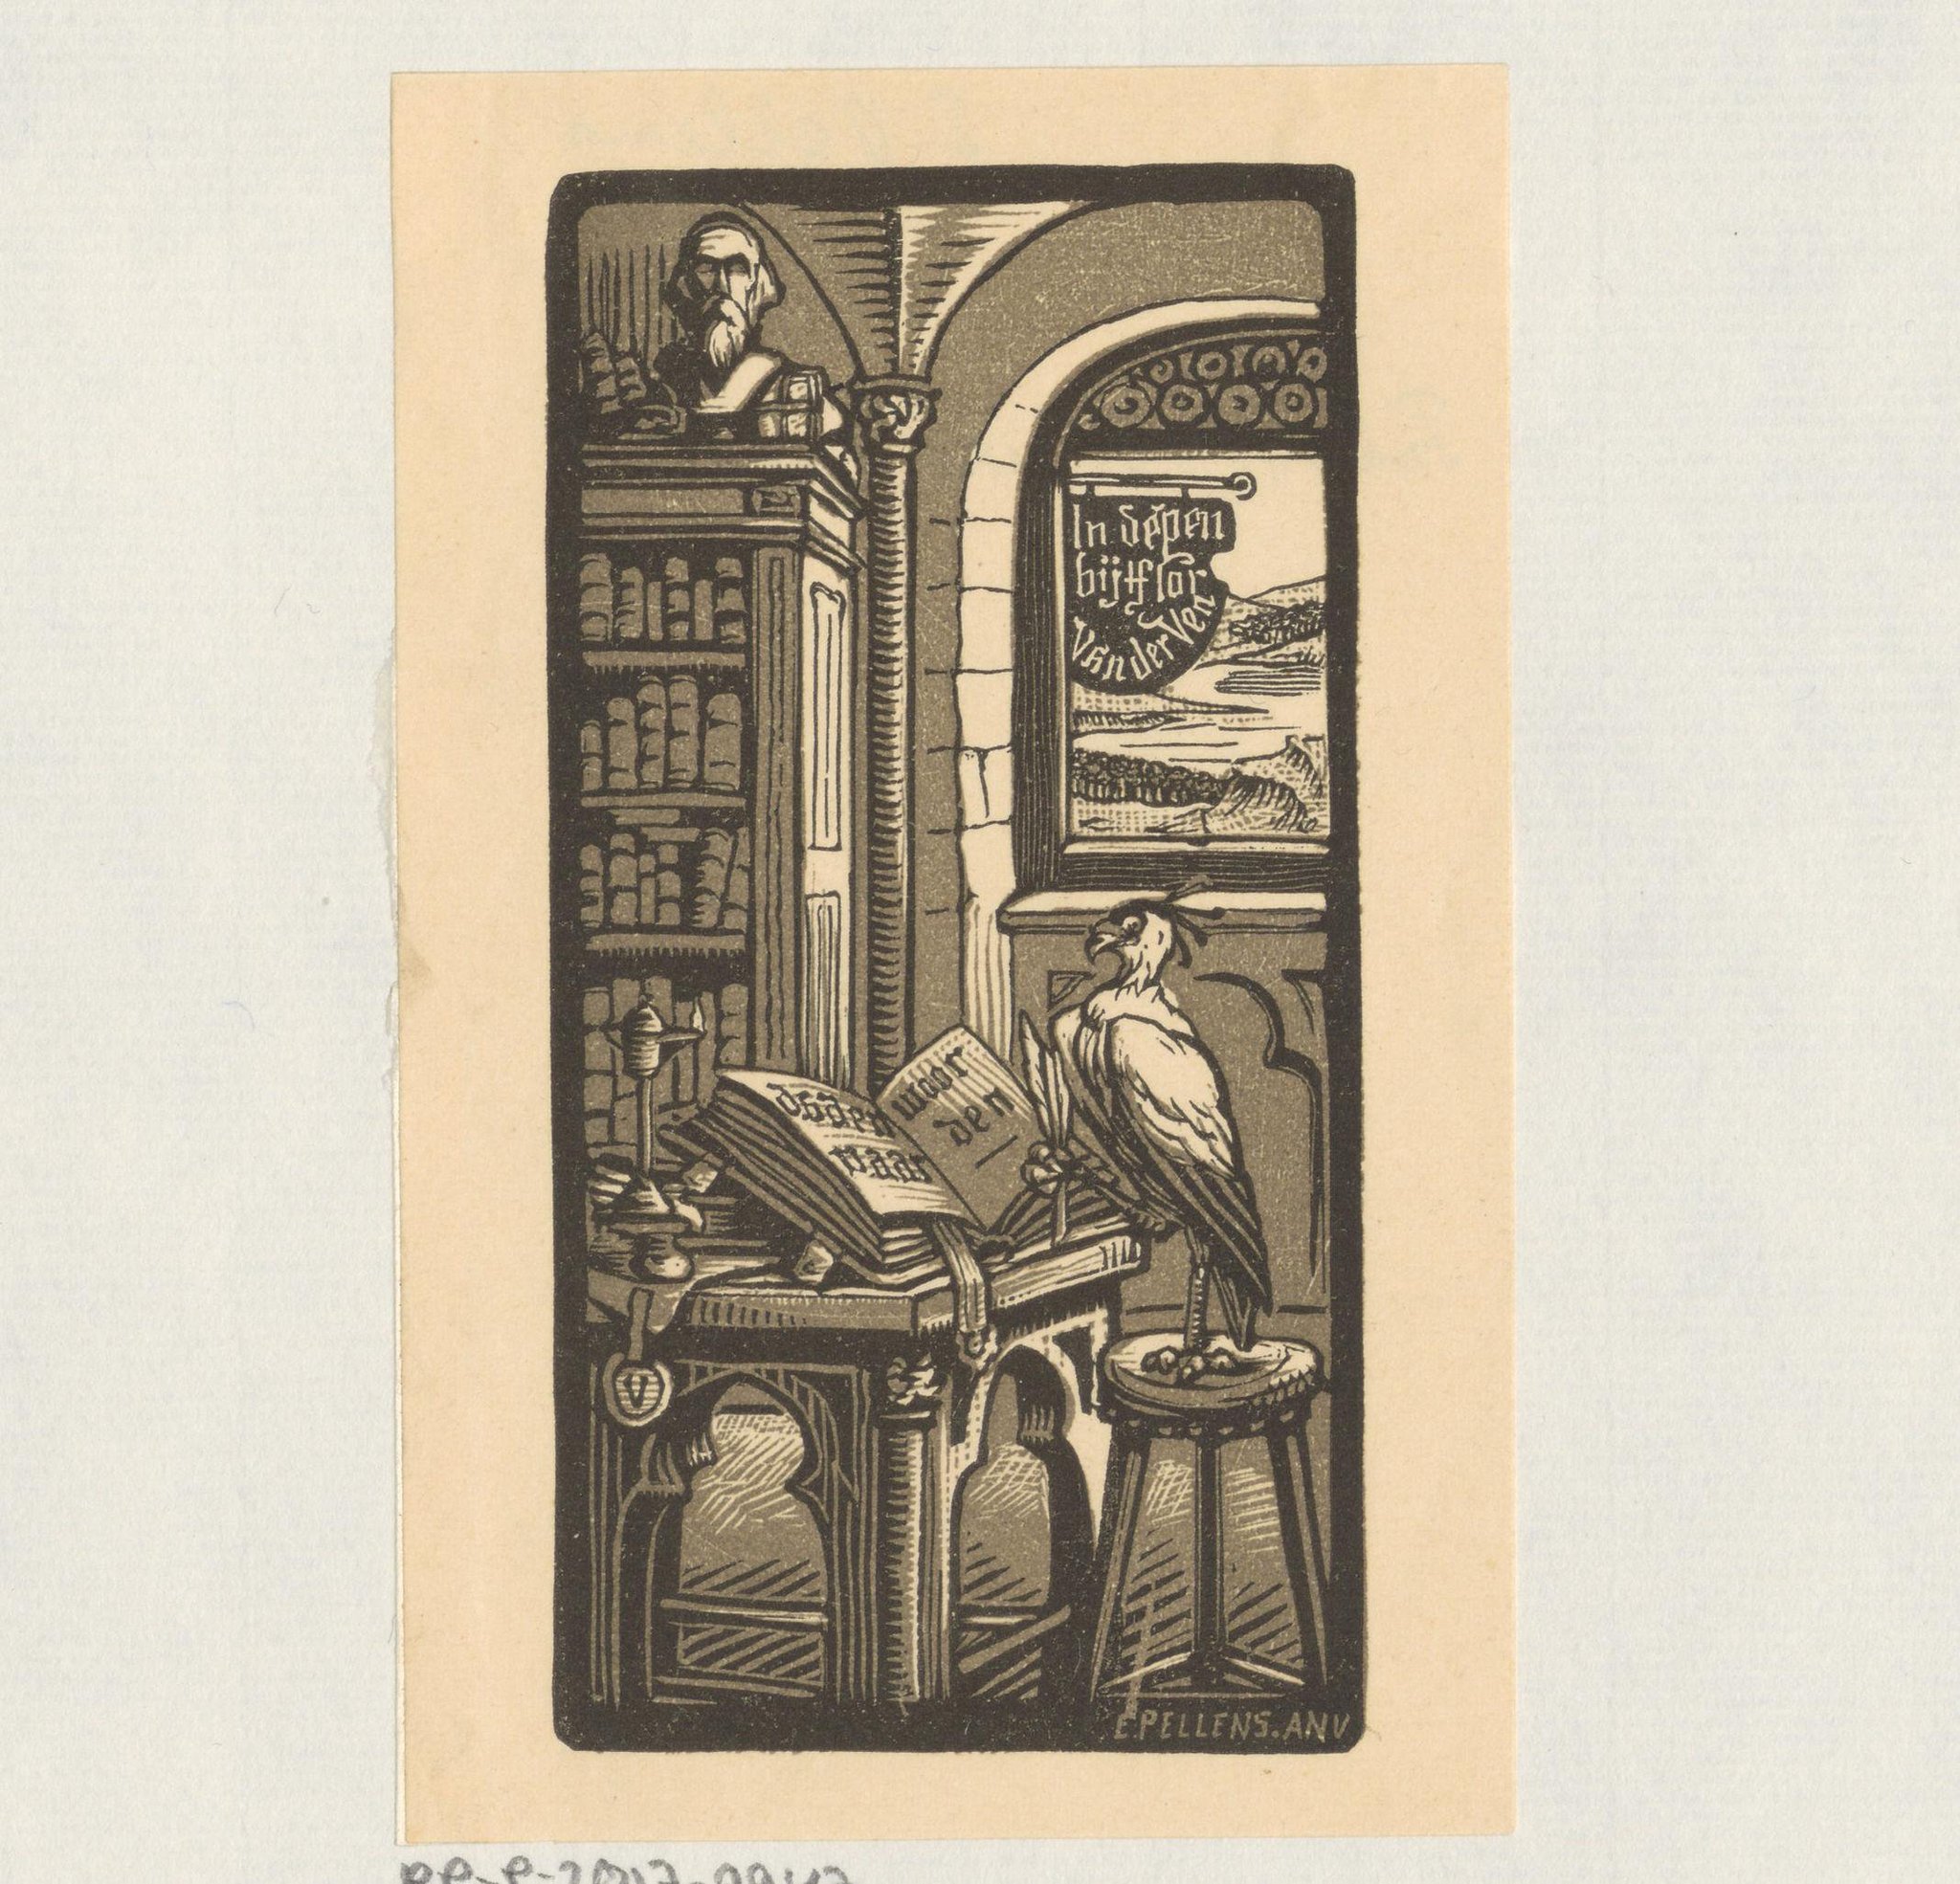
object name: bookplate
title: Ex libris van Van der Ven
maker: edward pellens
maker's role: print maker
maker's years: 1872-1947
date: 1882-1947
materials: paper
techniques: woodcut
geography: antwerp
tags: view through a window, study; 'studiolo'; library, book, predatory birds